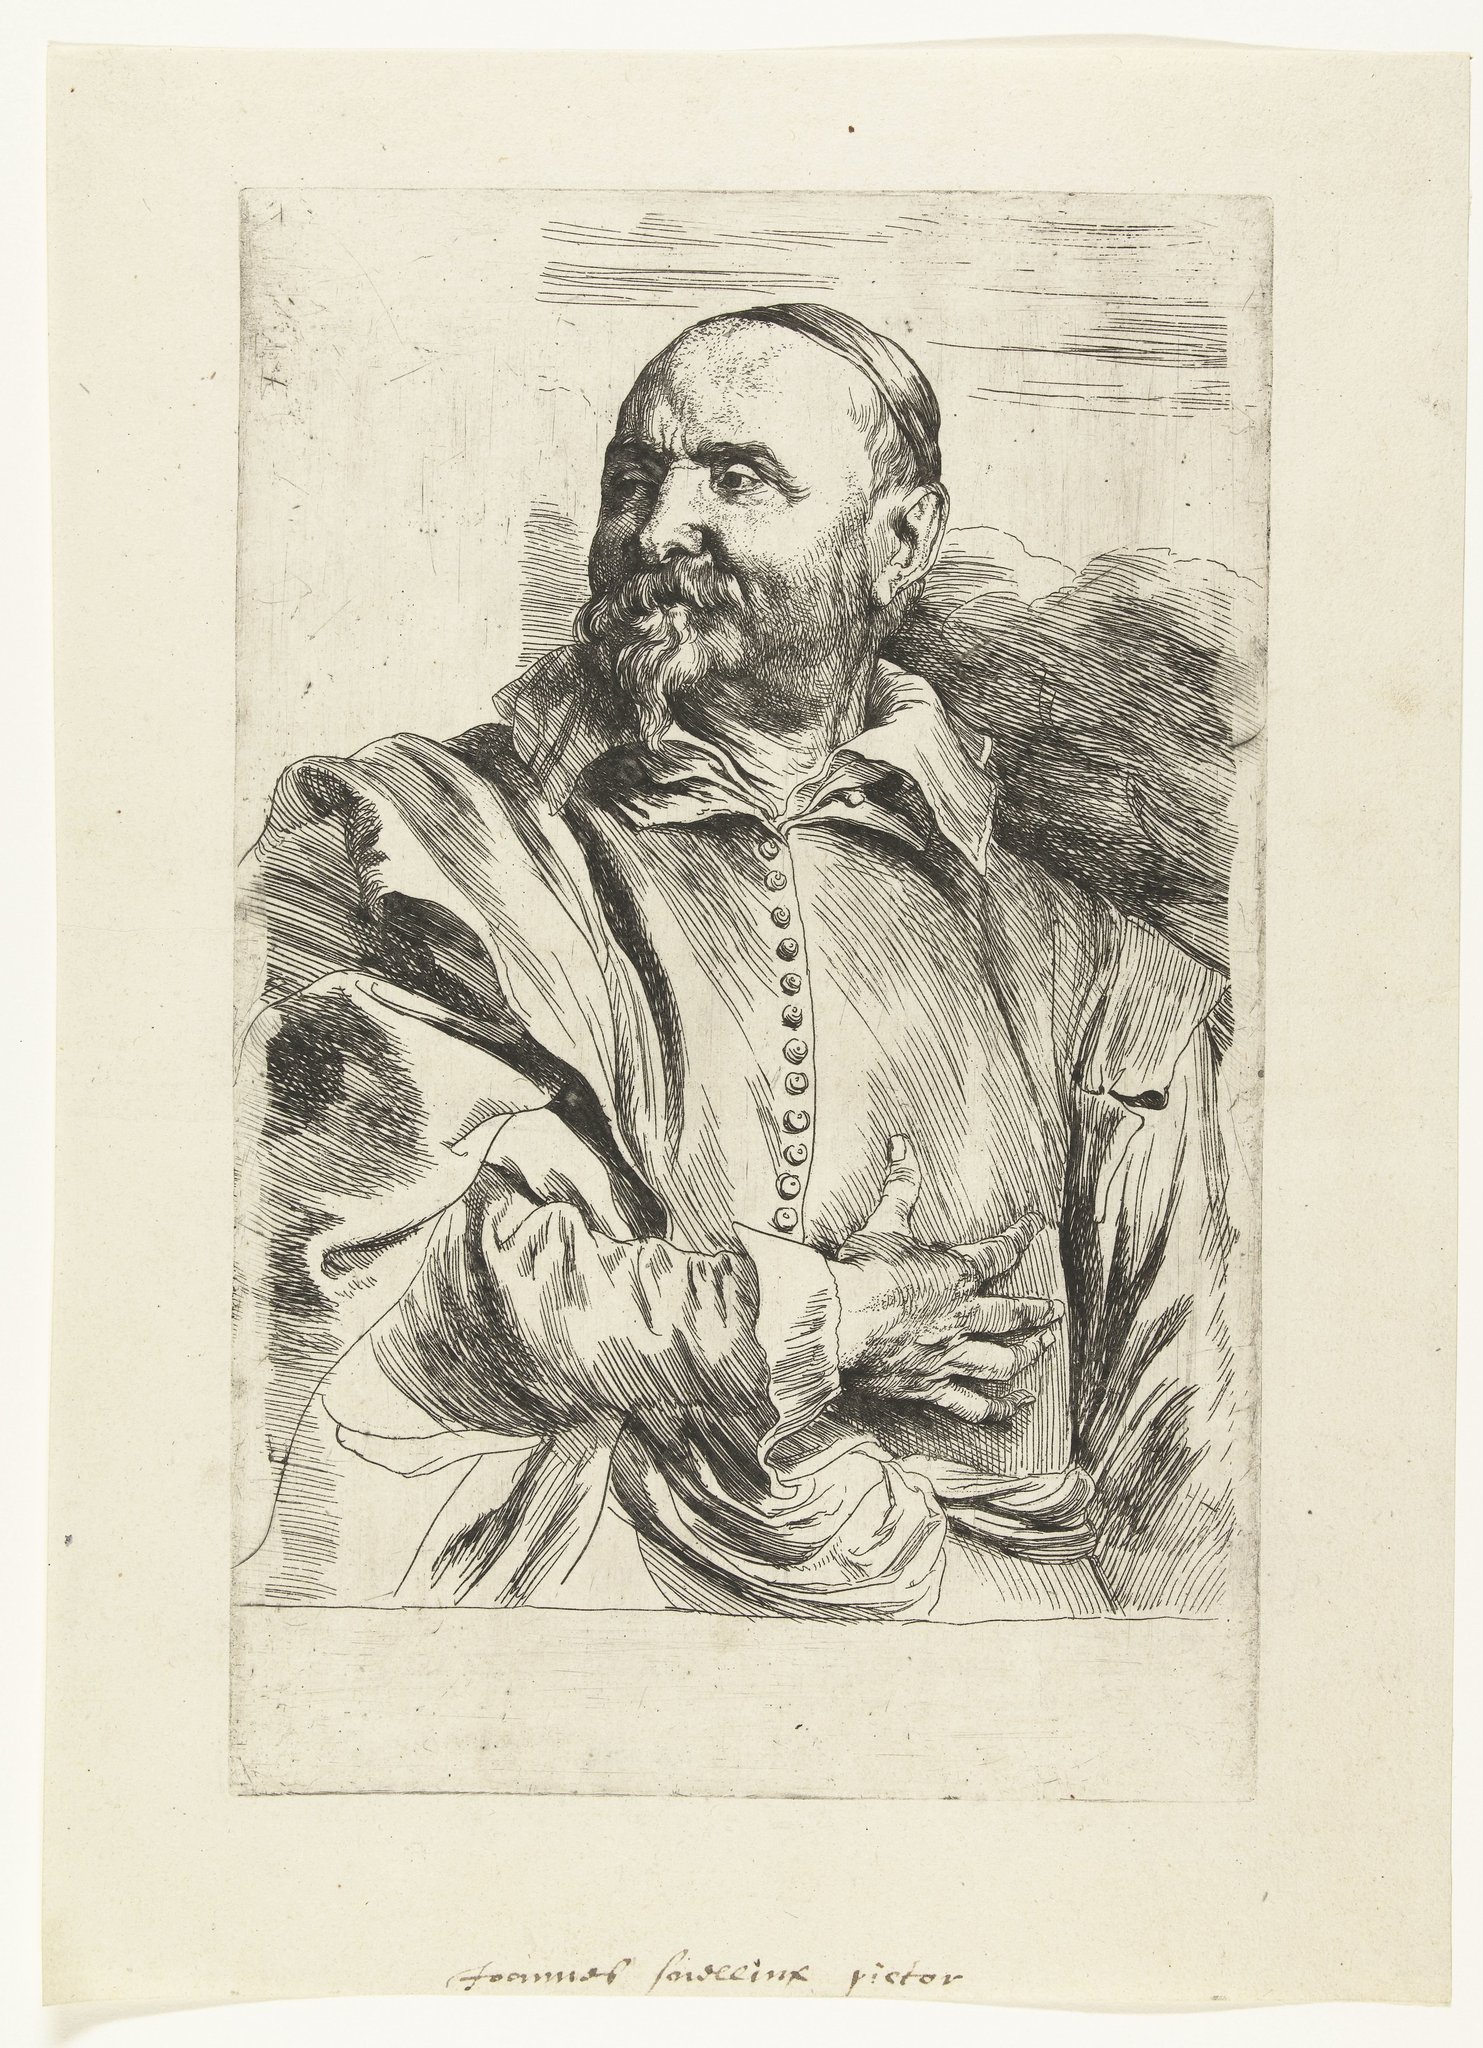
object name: print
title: Portret van Jan Snellinck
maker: anthony van dyck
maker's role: draughtsman, painter, print maker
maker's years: 1599-1641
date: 1630-1641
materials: paper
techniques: etching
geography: low countries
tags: jan snellinck (i), portrait, self-portrait of painter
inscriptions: inscription: ‘Joannes Schellinx pictor’, collector's mark: Lugt 240